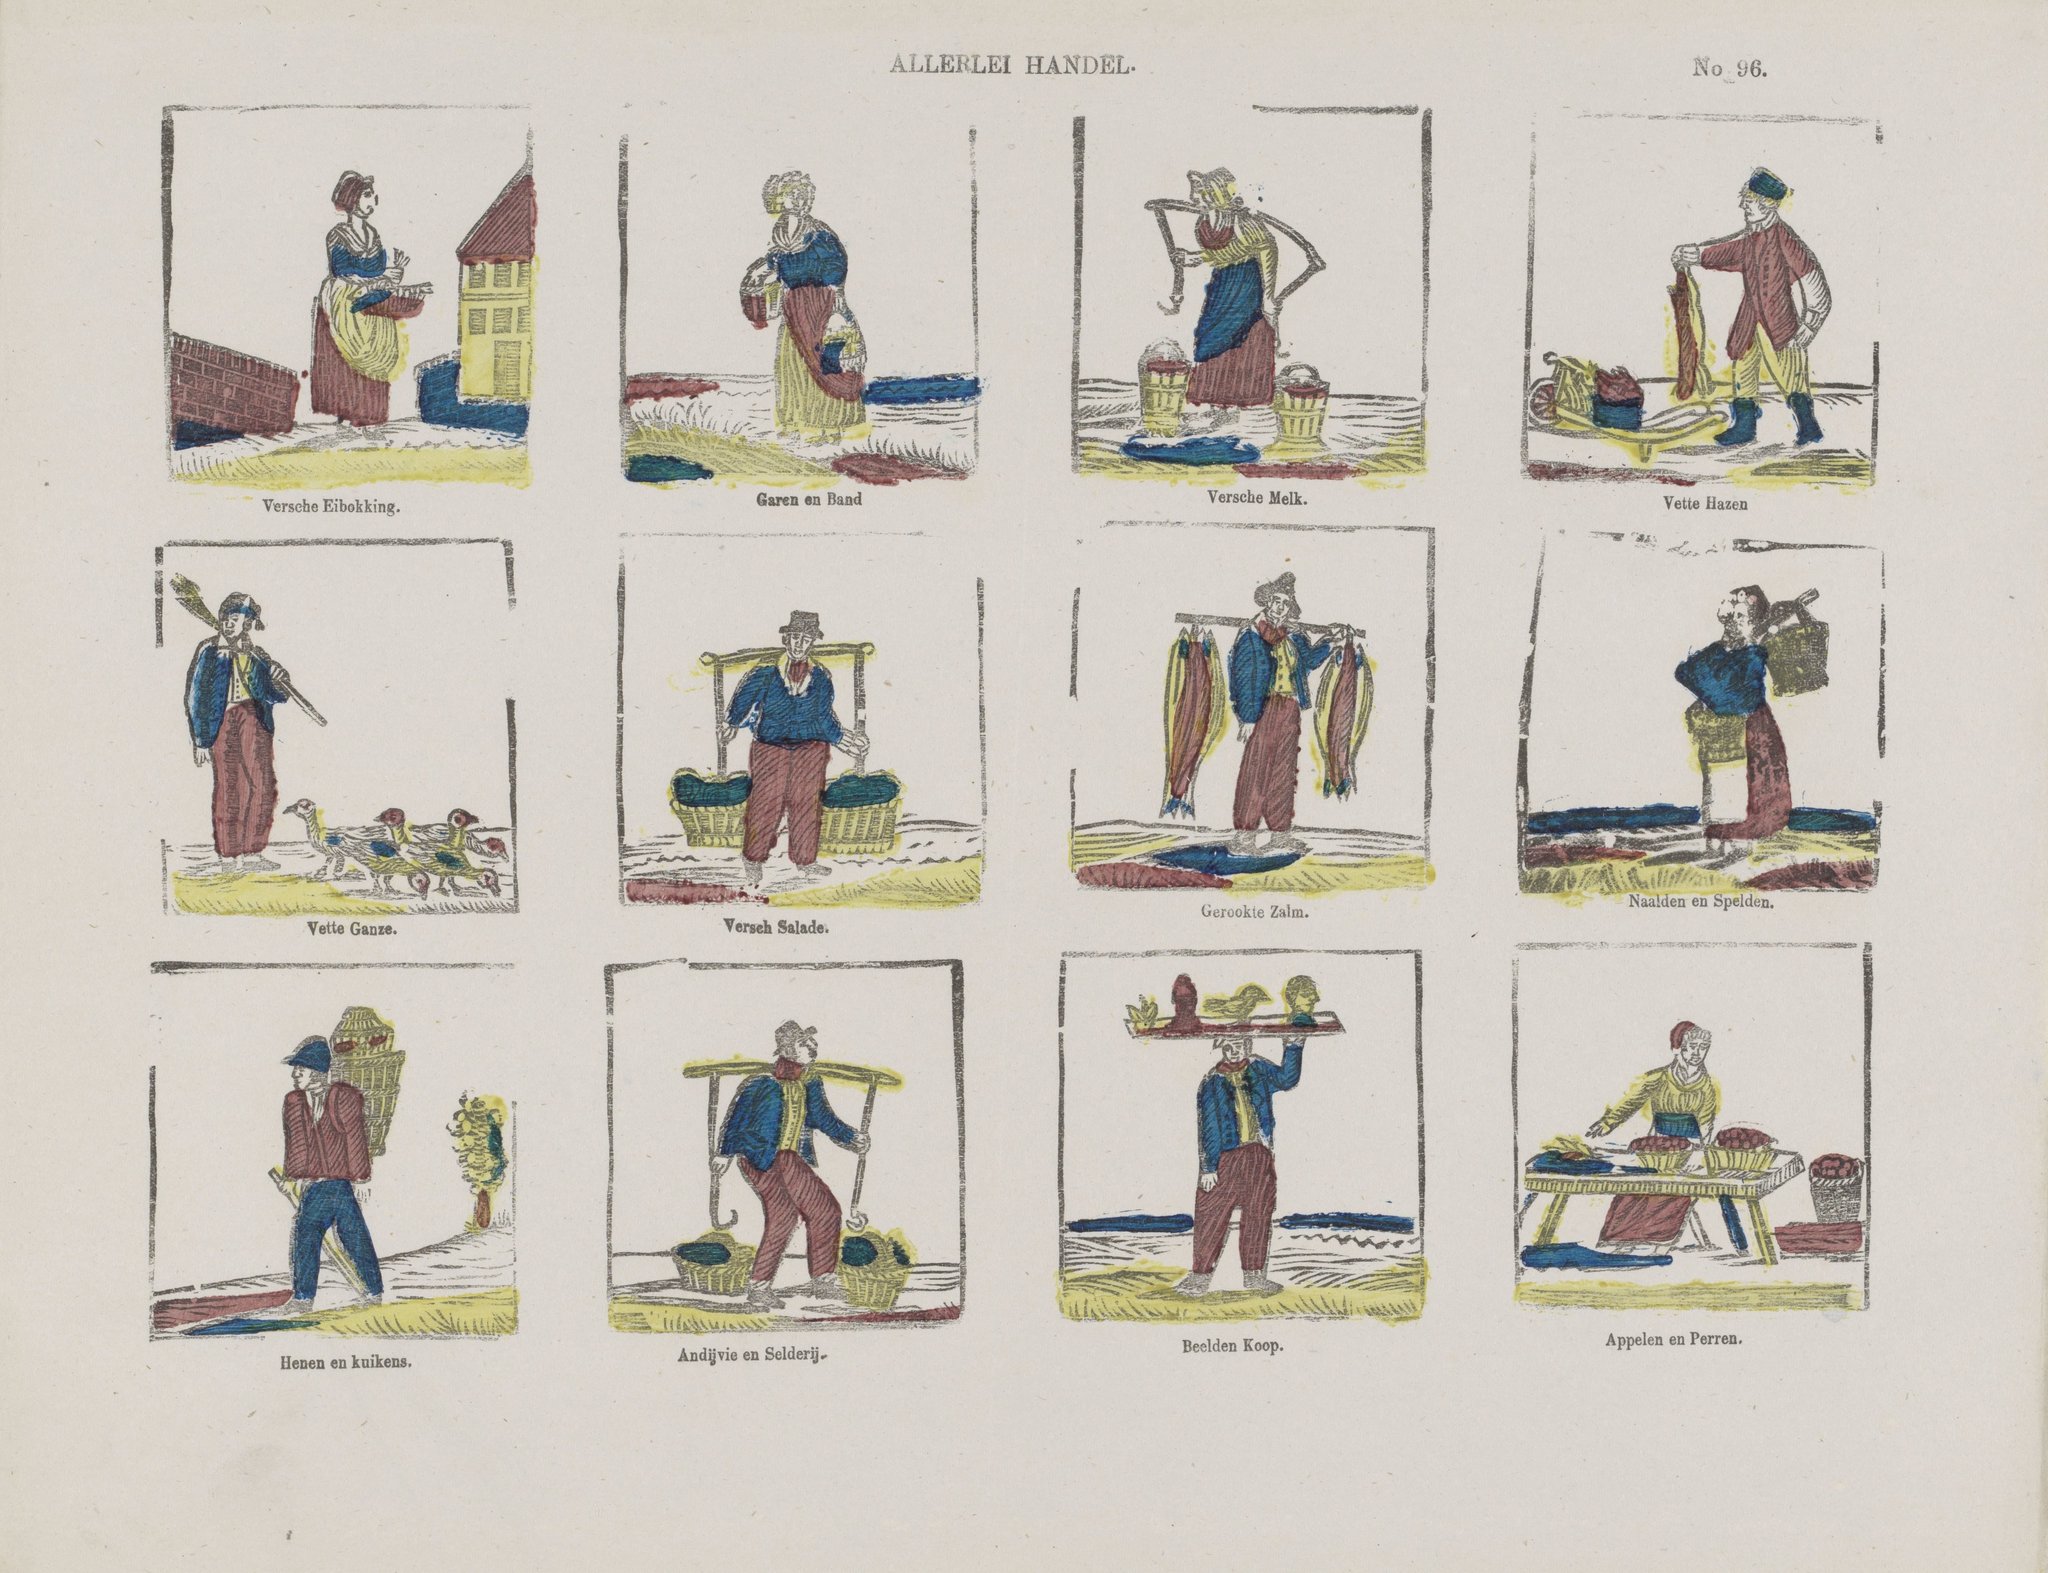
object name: print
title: Allerlei handel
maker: Anonymous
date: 1848-1881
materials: paper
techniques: colour, letterpress printing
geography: netherlands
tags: street-trader, merchant, salesman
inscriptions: collector's mark: Lugt 2760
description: Blad met 12 voorstellingen van straatverkopers. Onder elke afbeelding een onderschrift. Rechtsboven genummerd: No. 96.